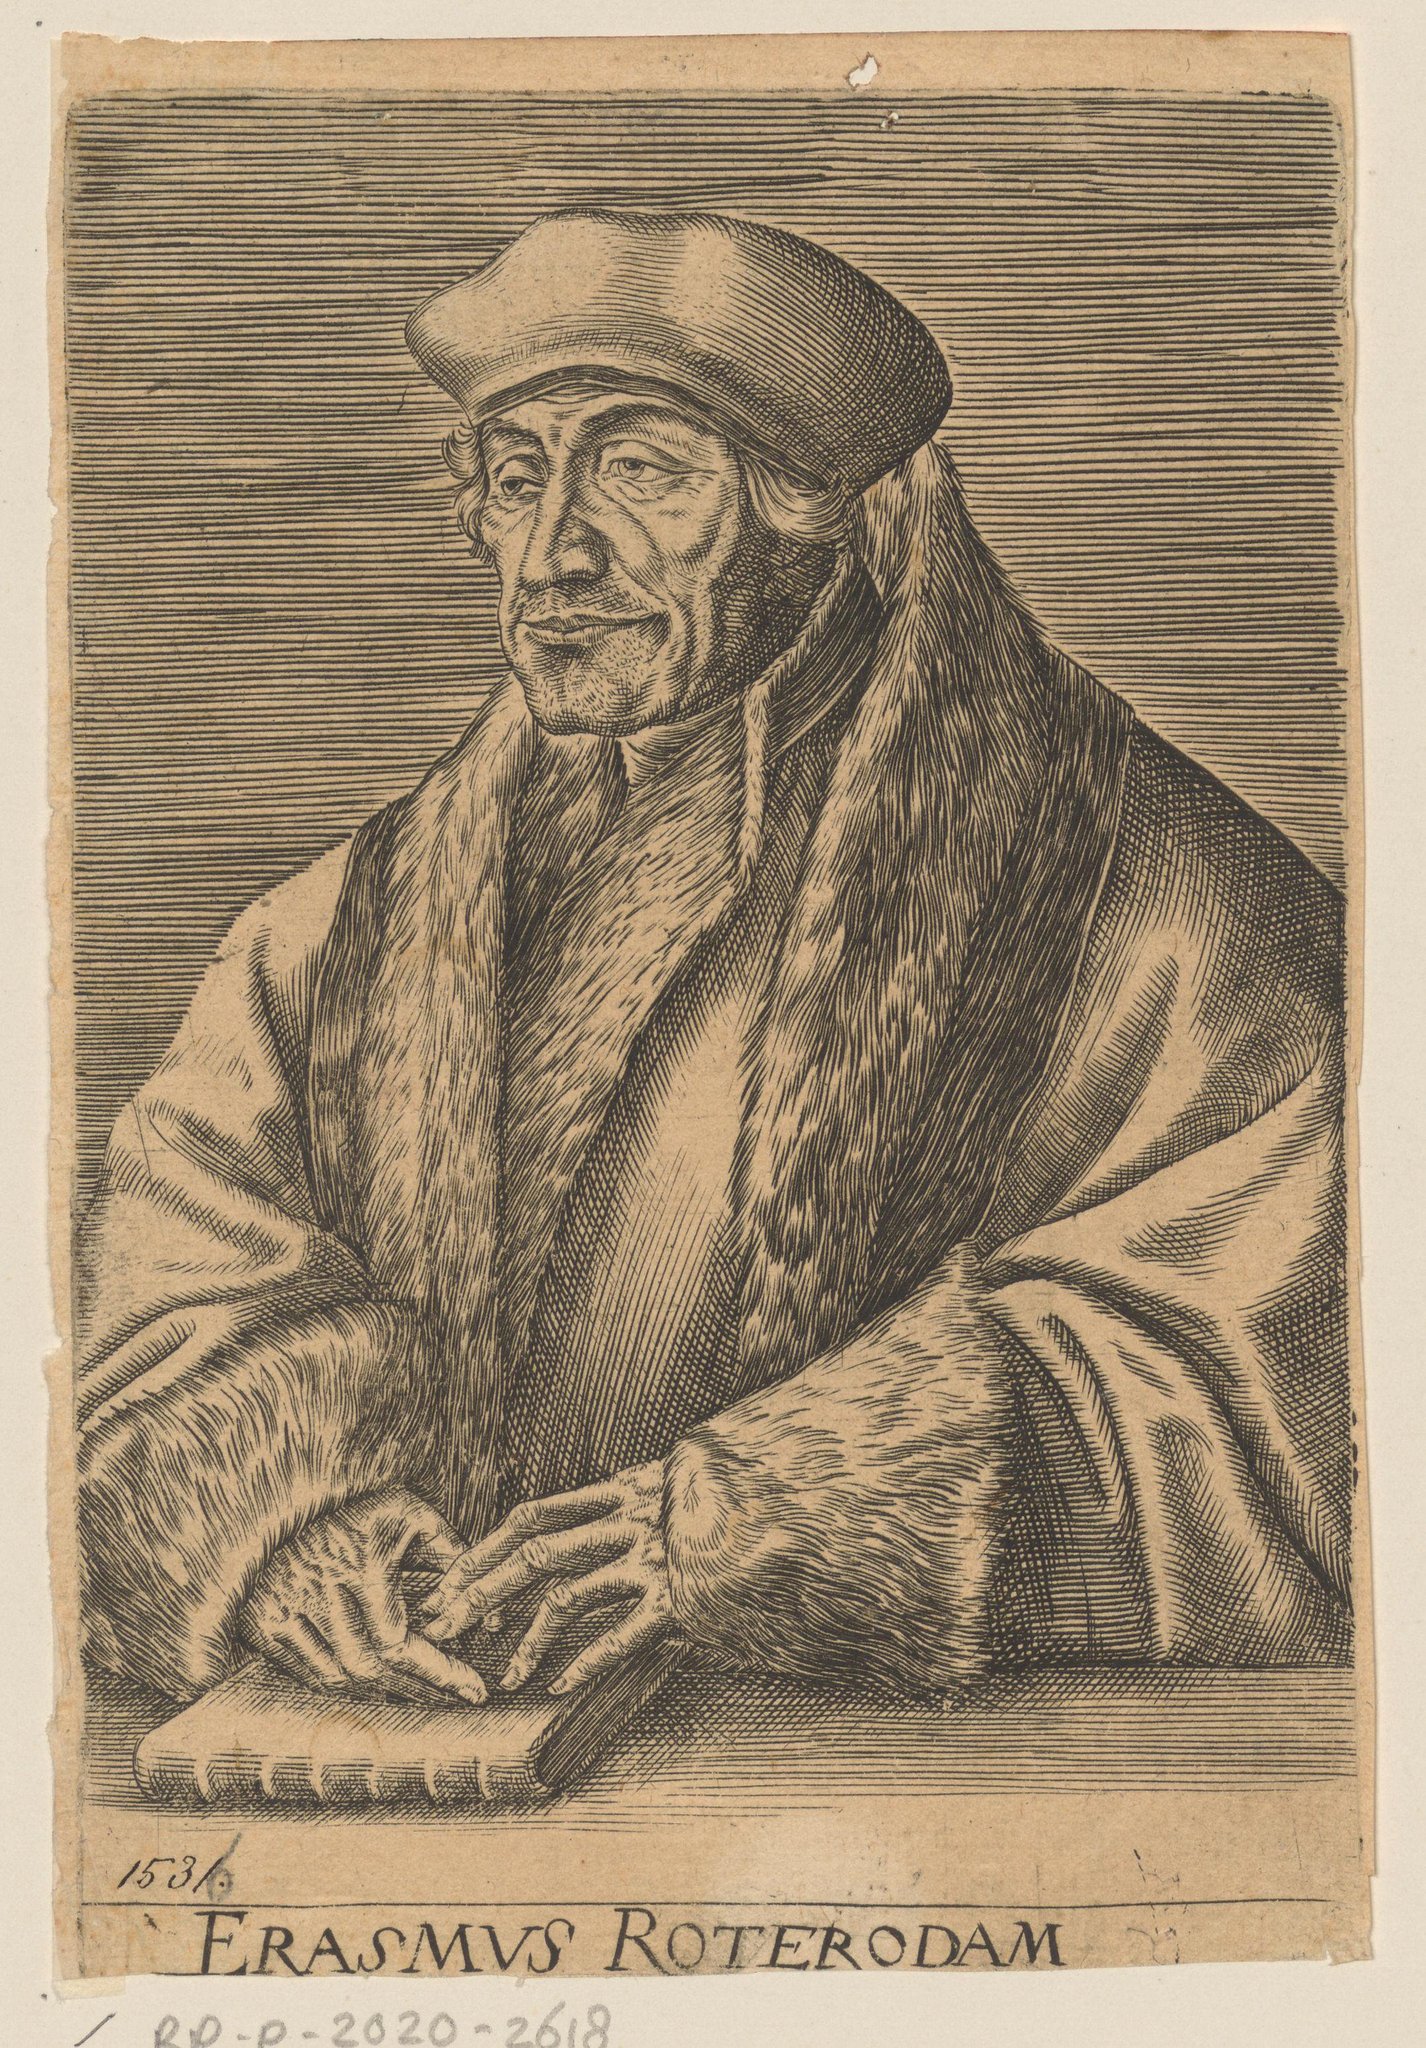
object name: print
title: Portret van Desiderius Erasmus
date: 1531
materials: paper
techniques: engraving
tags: rotterdam, desiderius erasmus, historical persons, book, scholar, philosopher (+ portrait of scholar, scientist)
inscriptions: date